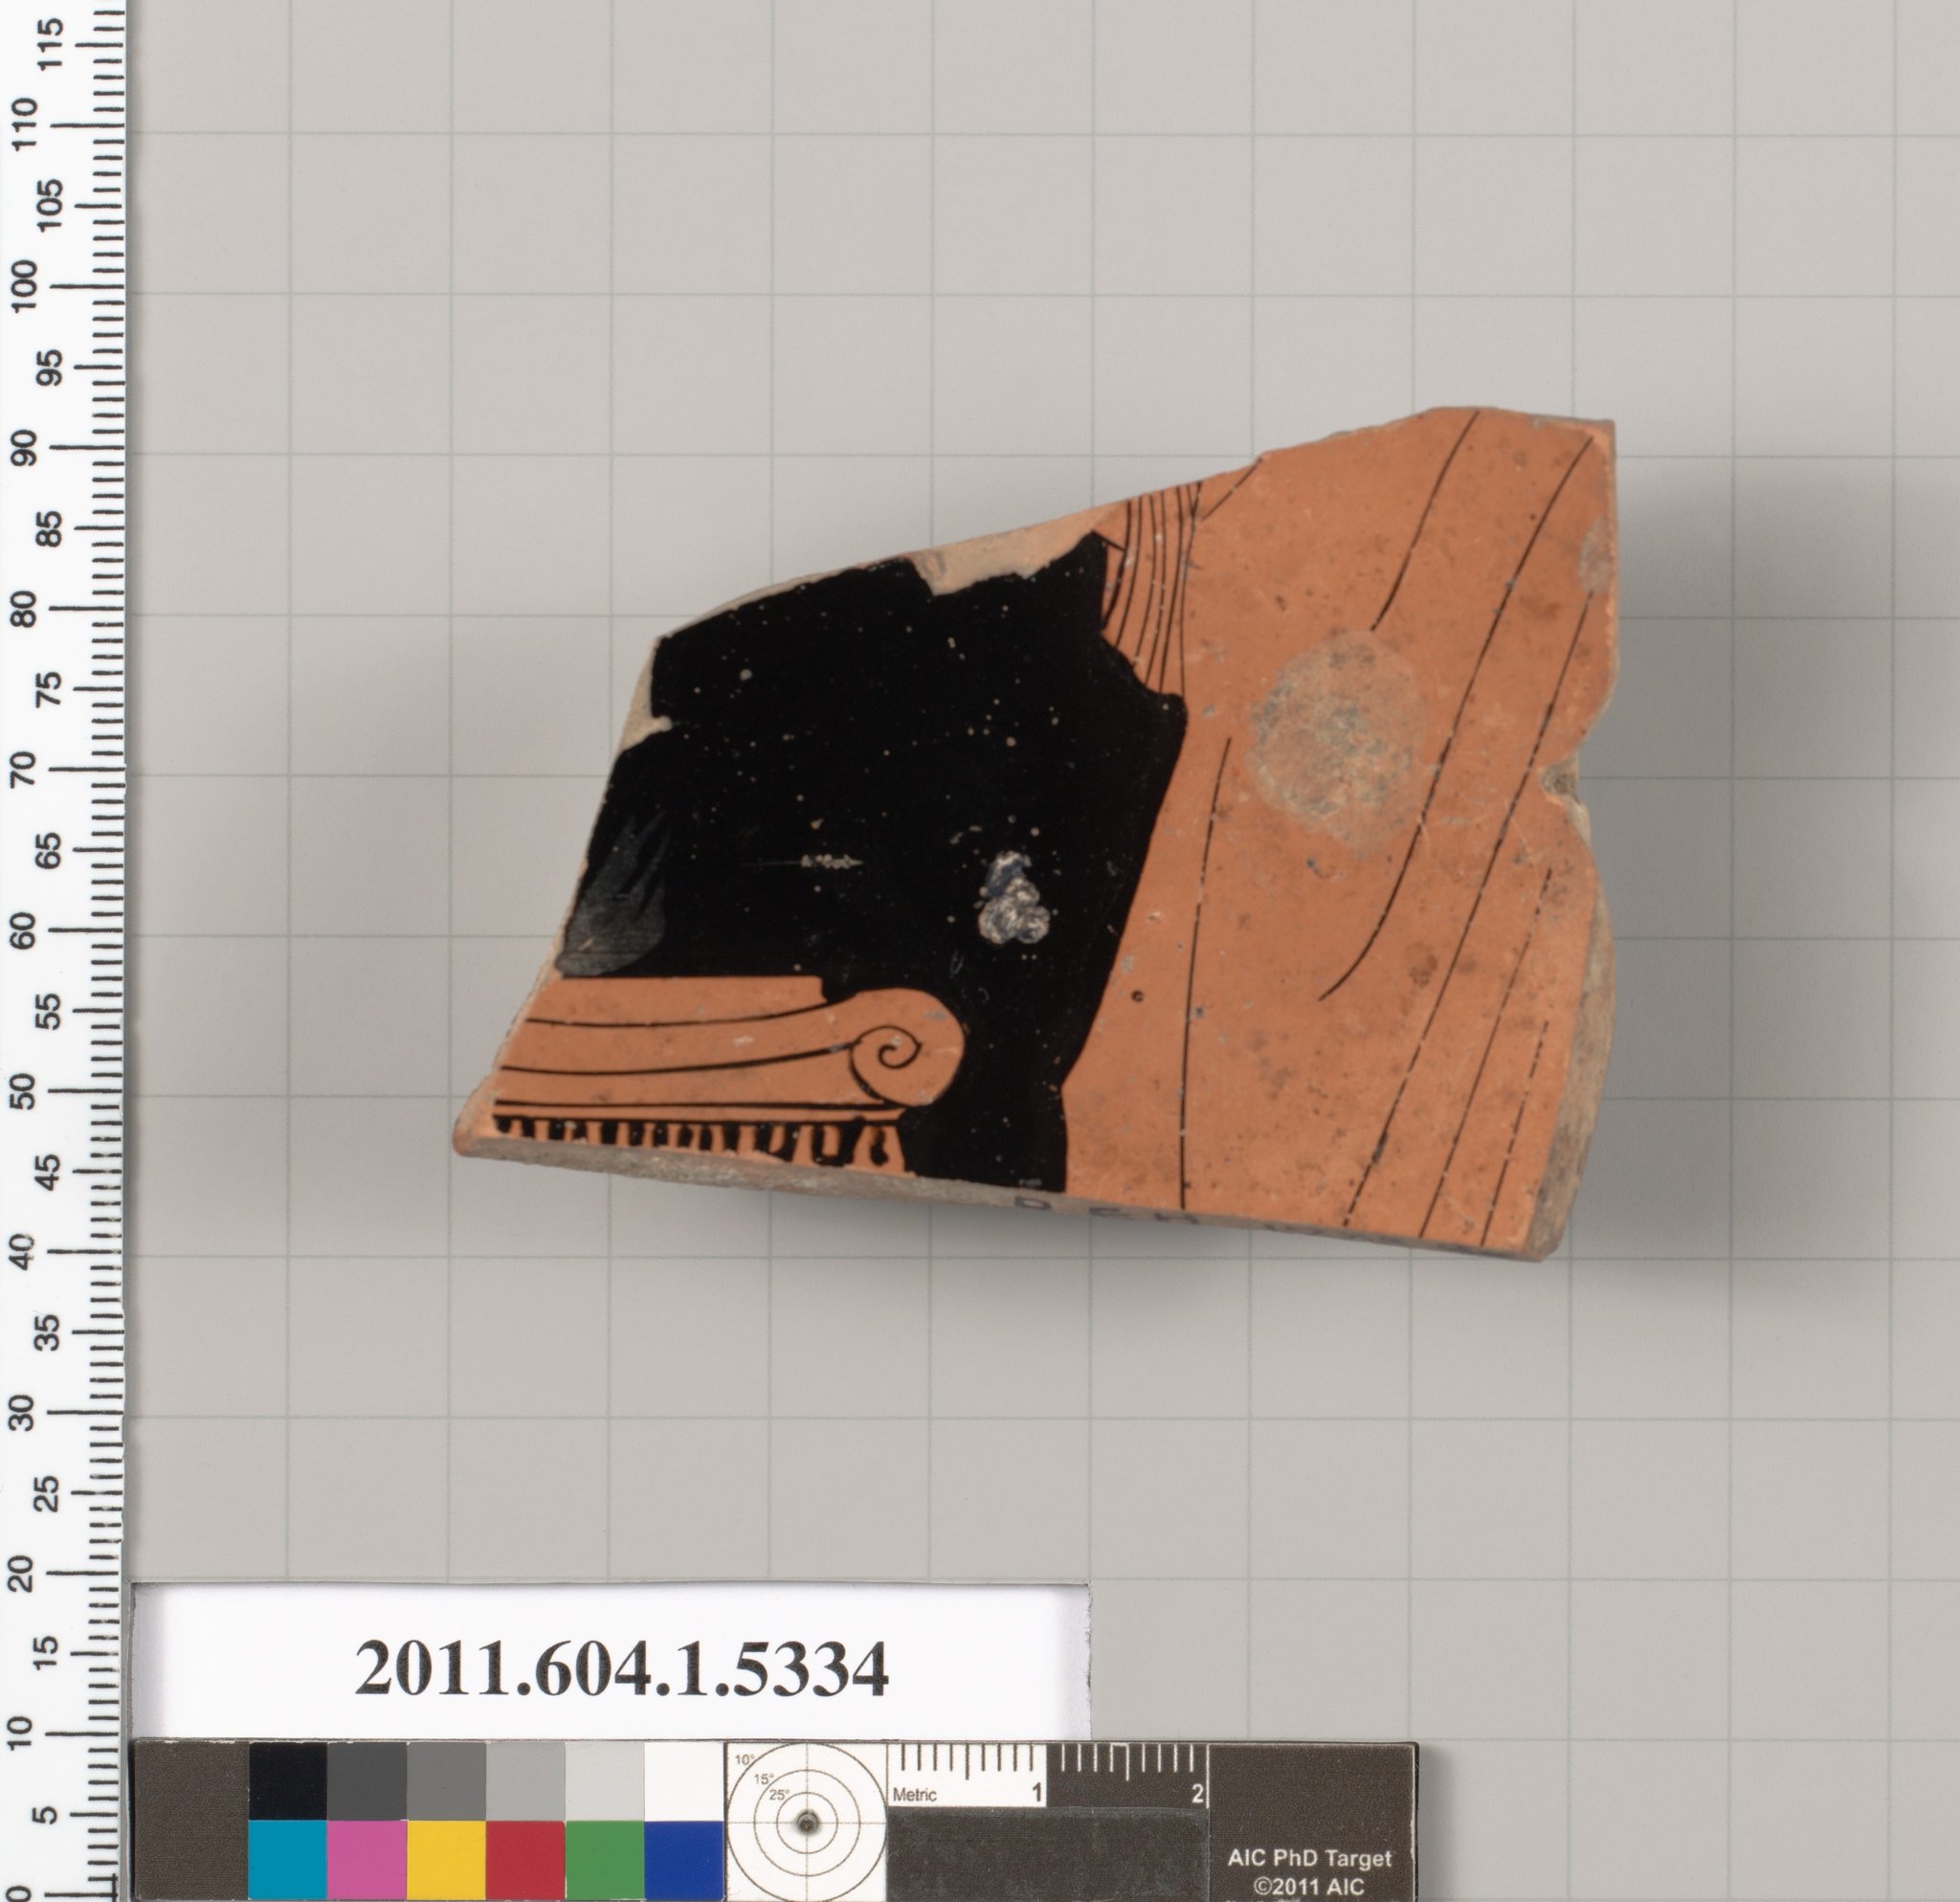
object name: kylix fragment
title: Terracotta fragment of a kylix (drinking cup)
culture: greek, attic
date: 475-451 BCE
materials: terracotta